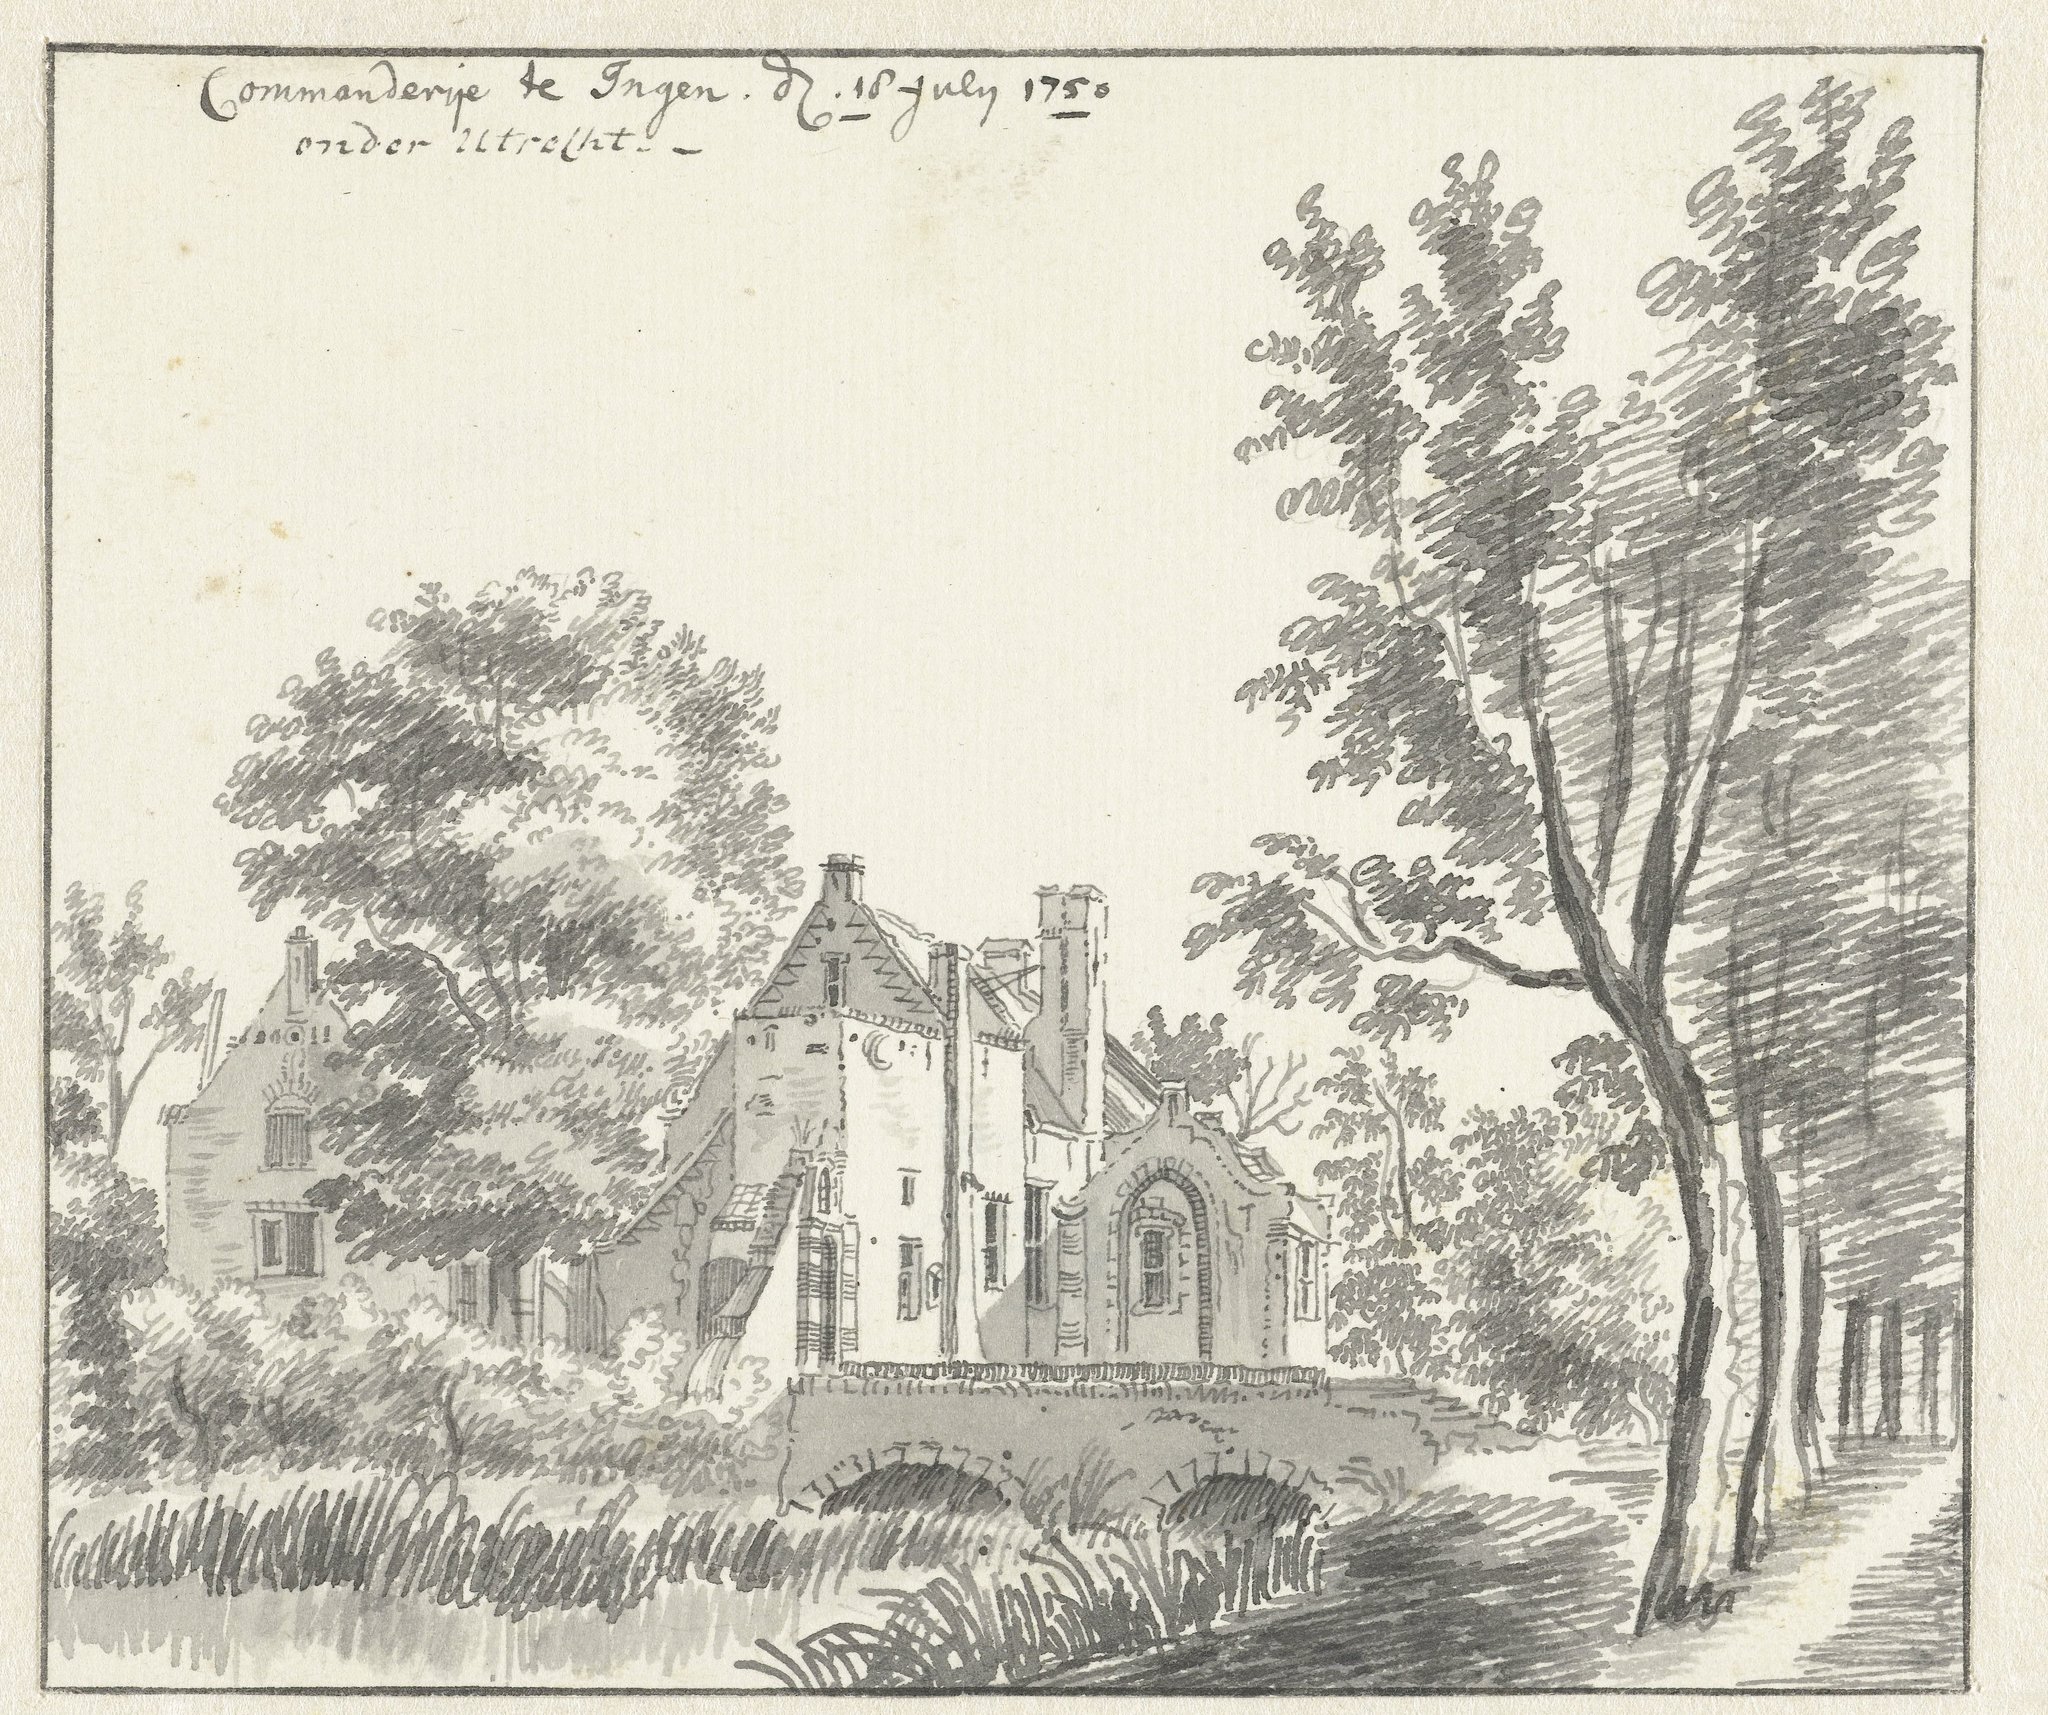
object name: drawing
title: Commanderije te Ingen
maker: jan de beijer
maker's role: draughtsman, print maker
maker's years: 1703-1780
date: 1750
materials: ink, paper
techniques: brush, pen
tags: castle